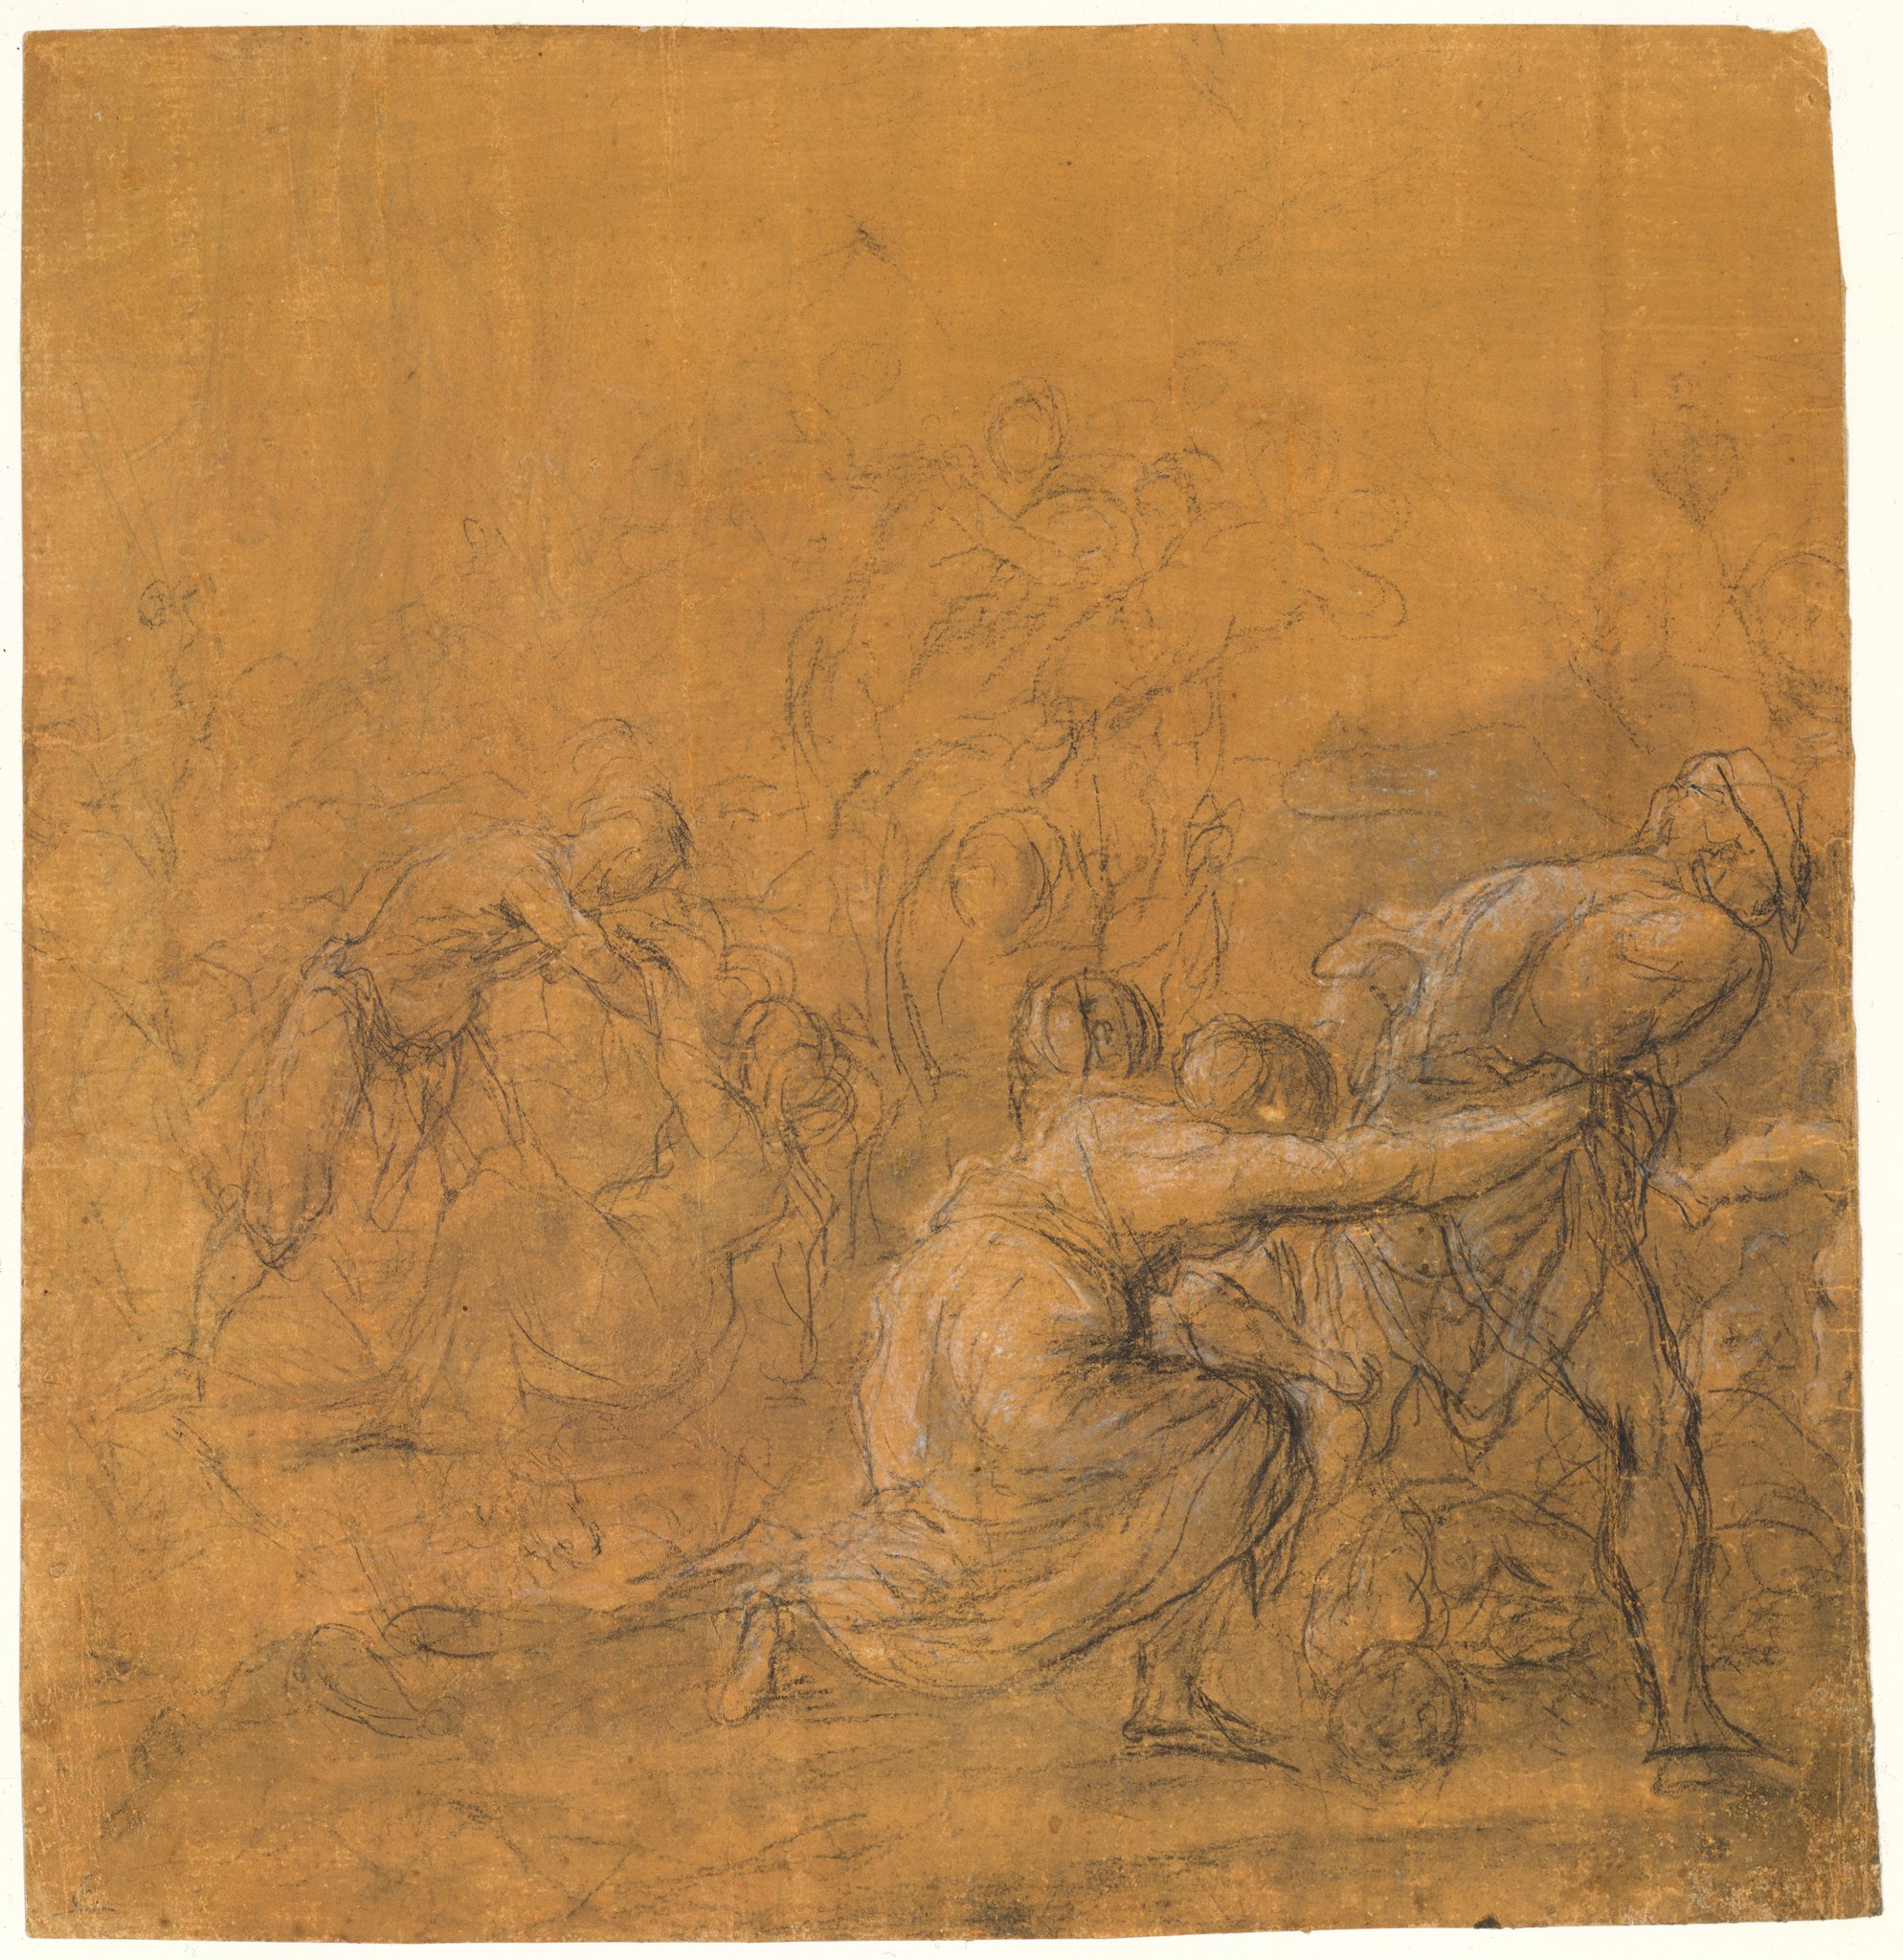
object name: drawing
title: The Massacre of the Innocents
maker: the veneto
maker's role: artist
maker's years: 1600-1699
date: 1601-1700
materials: chalk, paper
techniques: heightening, tinting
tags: massacres,men,women